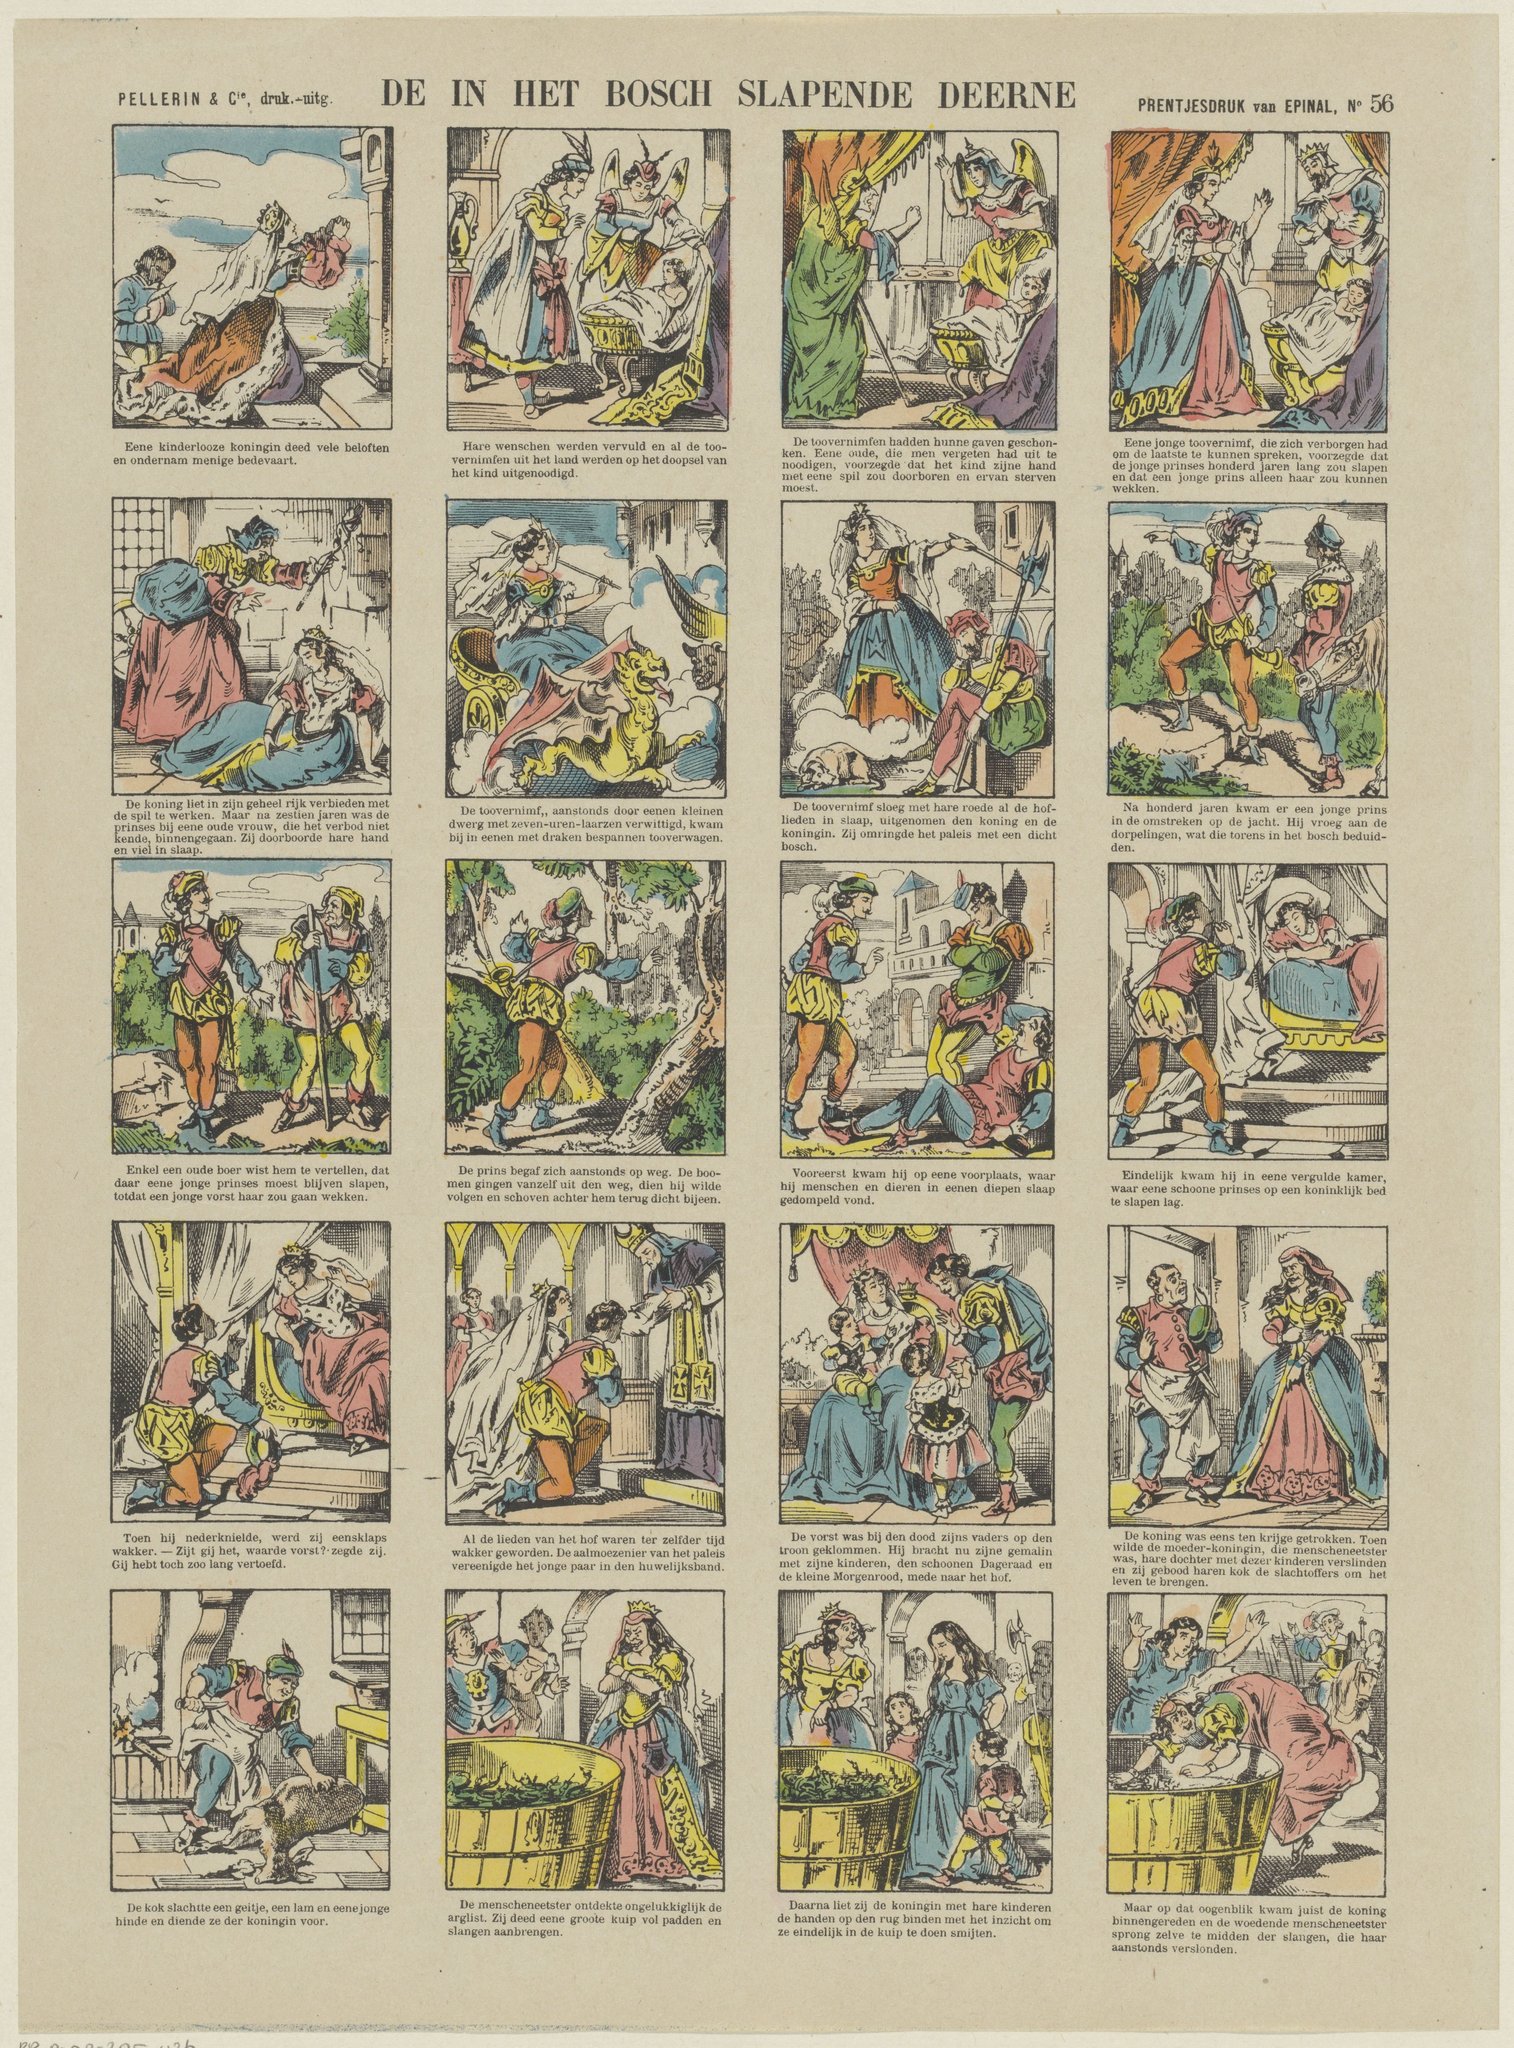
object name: print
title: De in het bosch slapende deerne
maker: Anonymous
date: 1902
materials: paper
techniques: colour, letterpress printing, lithograph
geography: epinal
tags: tales and fairy tales: sleeping beauty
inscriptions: collector's mark: Lugt 2760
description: Blad met 20 voorstellingen uit het sprookje van de Schone Slaapster. Onder elke afbeelding een onderschrift. Genummerd rechtsboven: No 56.